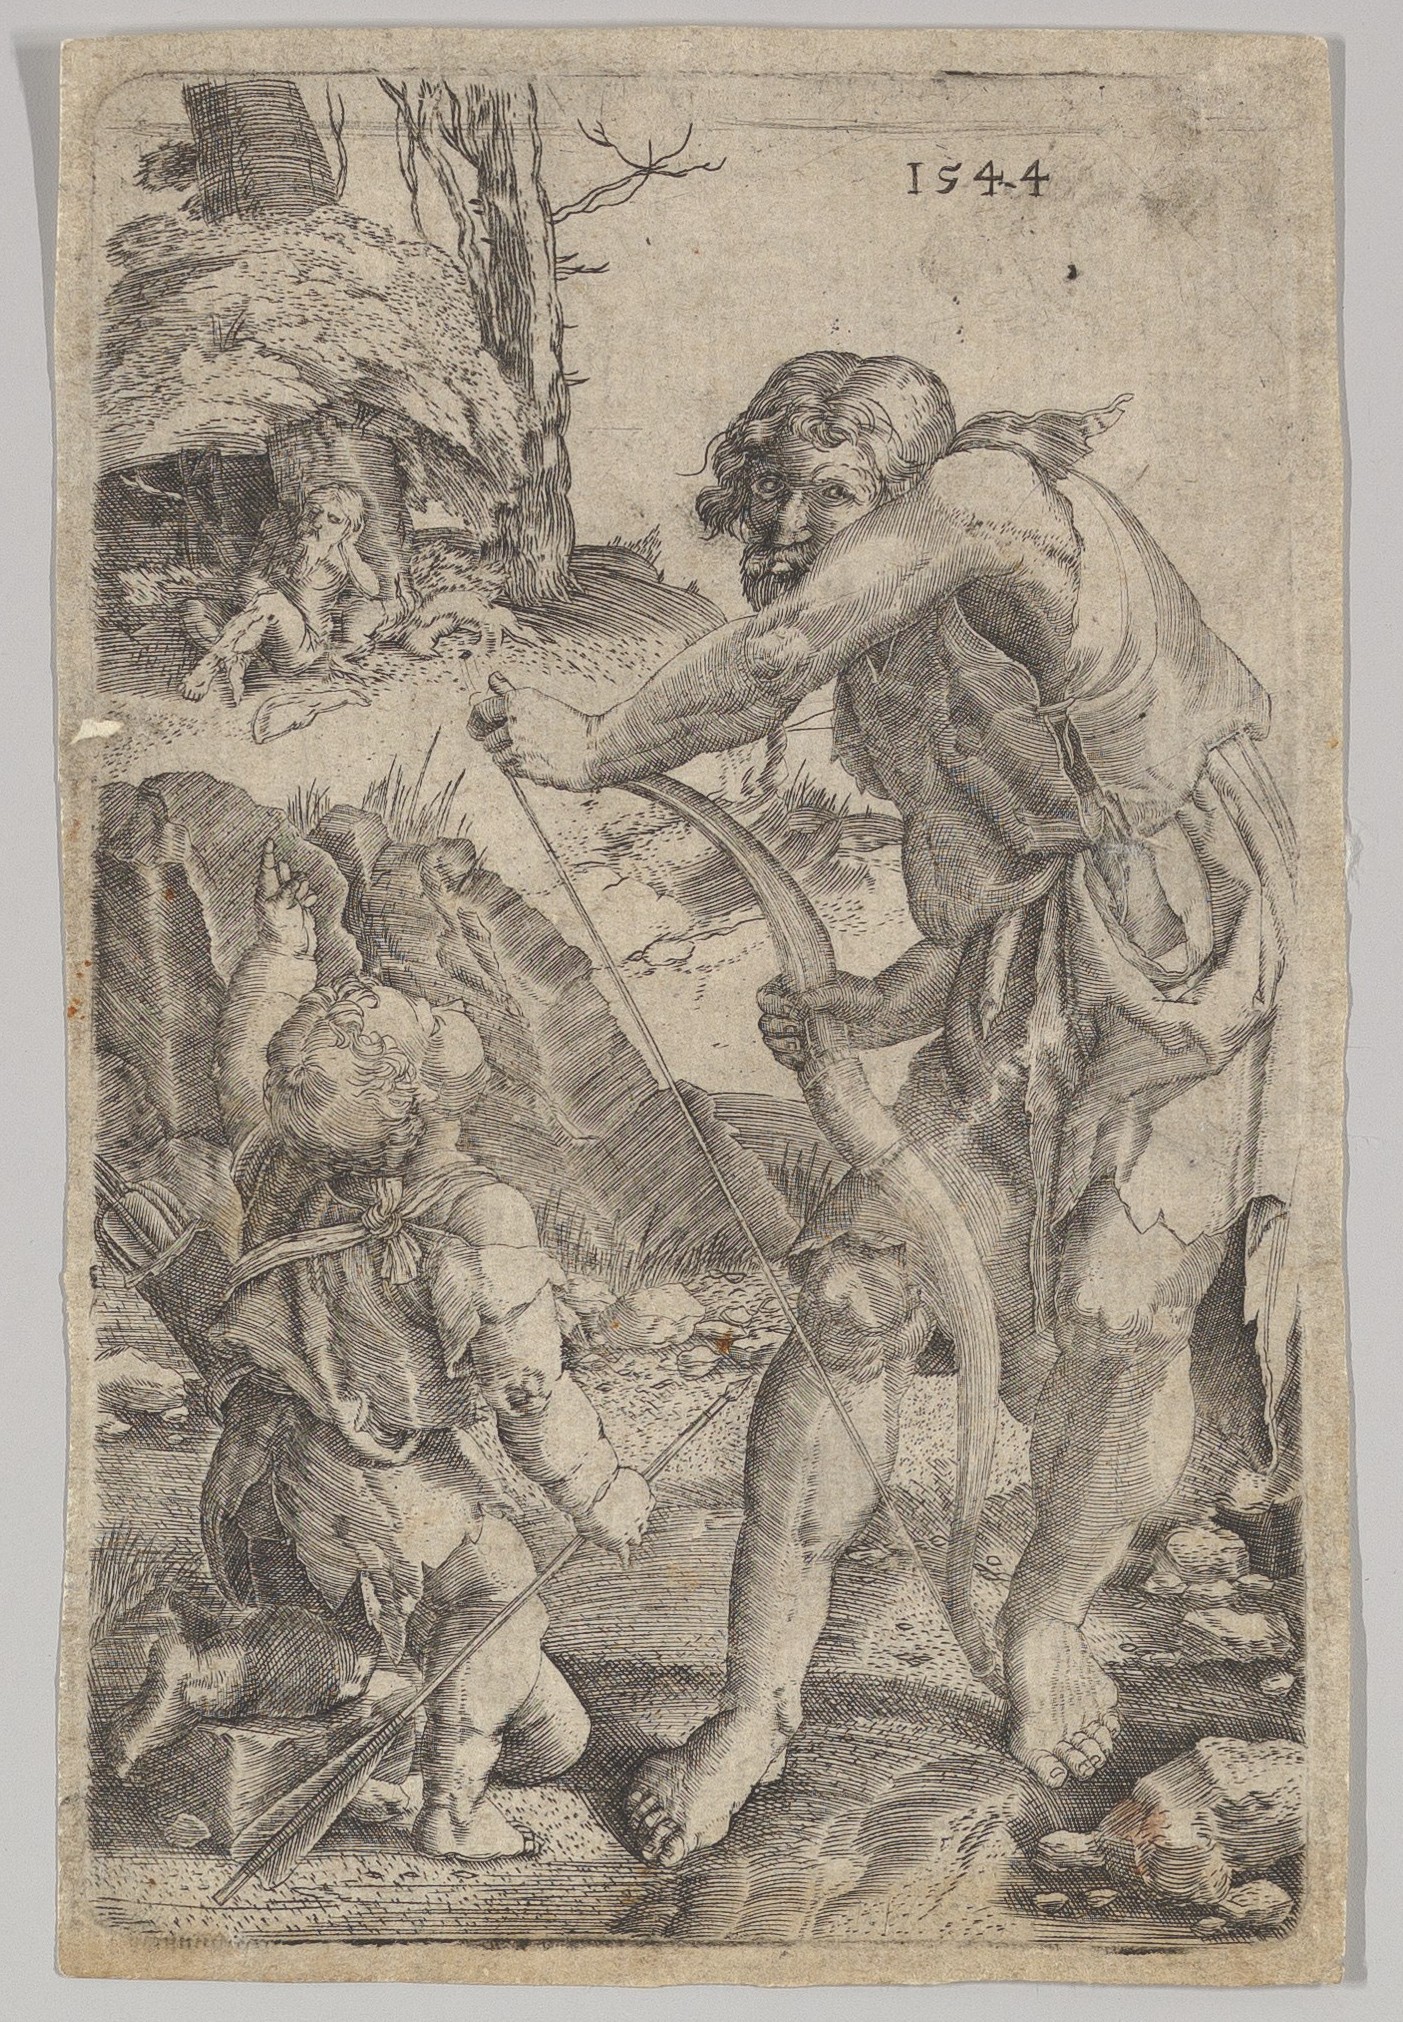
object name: print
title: Lamech and Cain (reverse copy)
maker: lucas van leyden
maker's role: artist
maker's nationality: netherlandish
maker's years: 1494-1533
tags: bow and arrow,children,cain